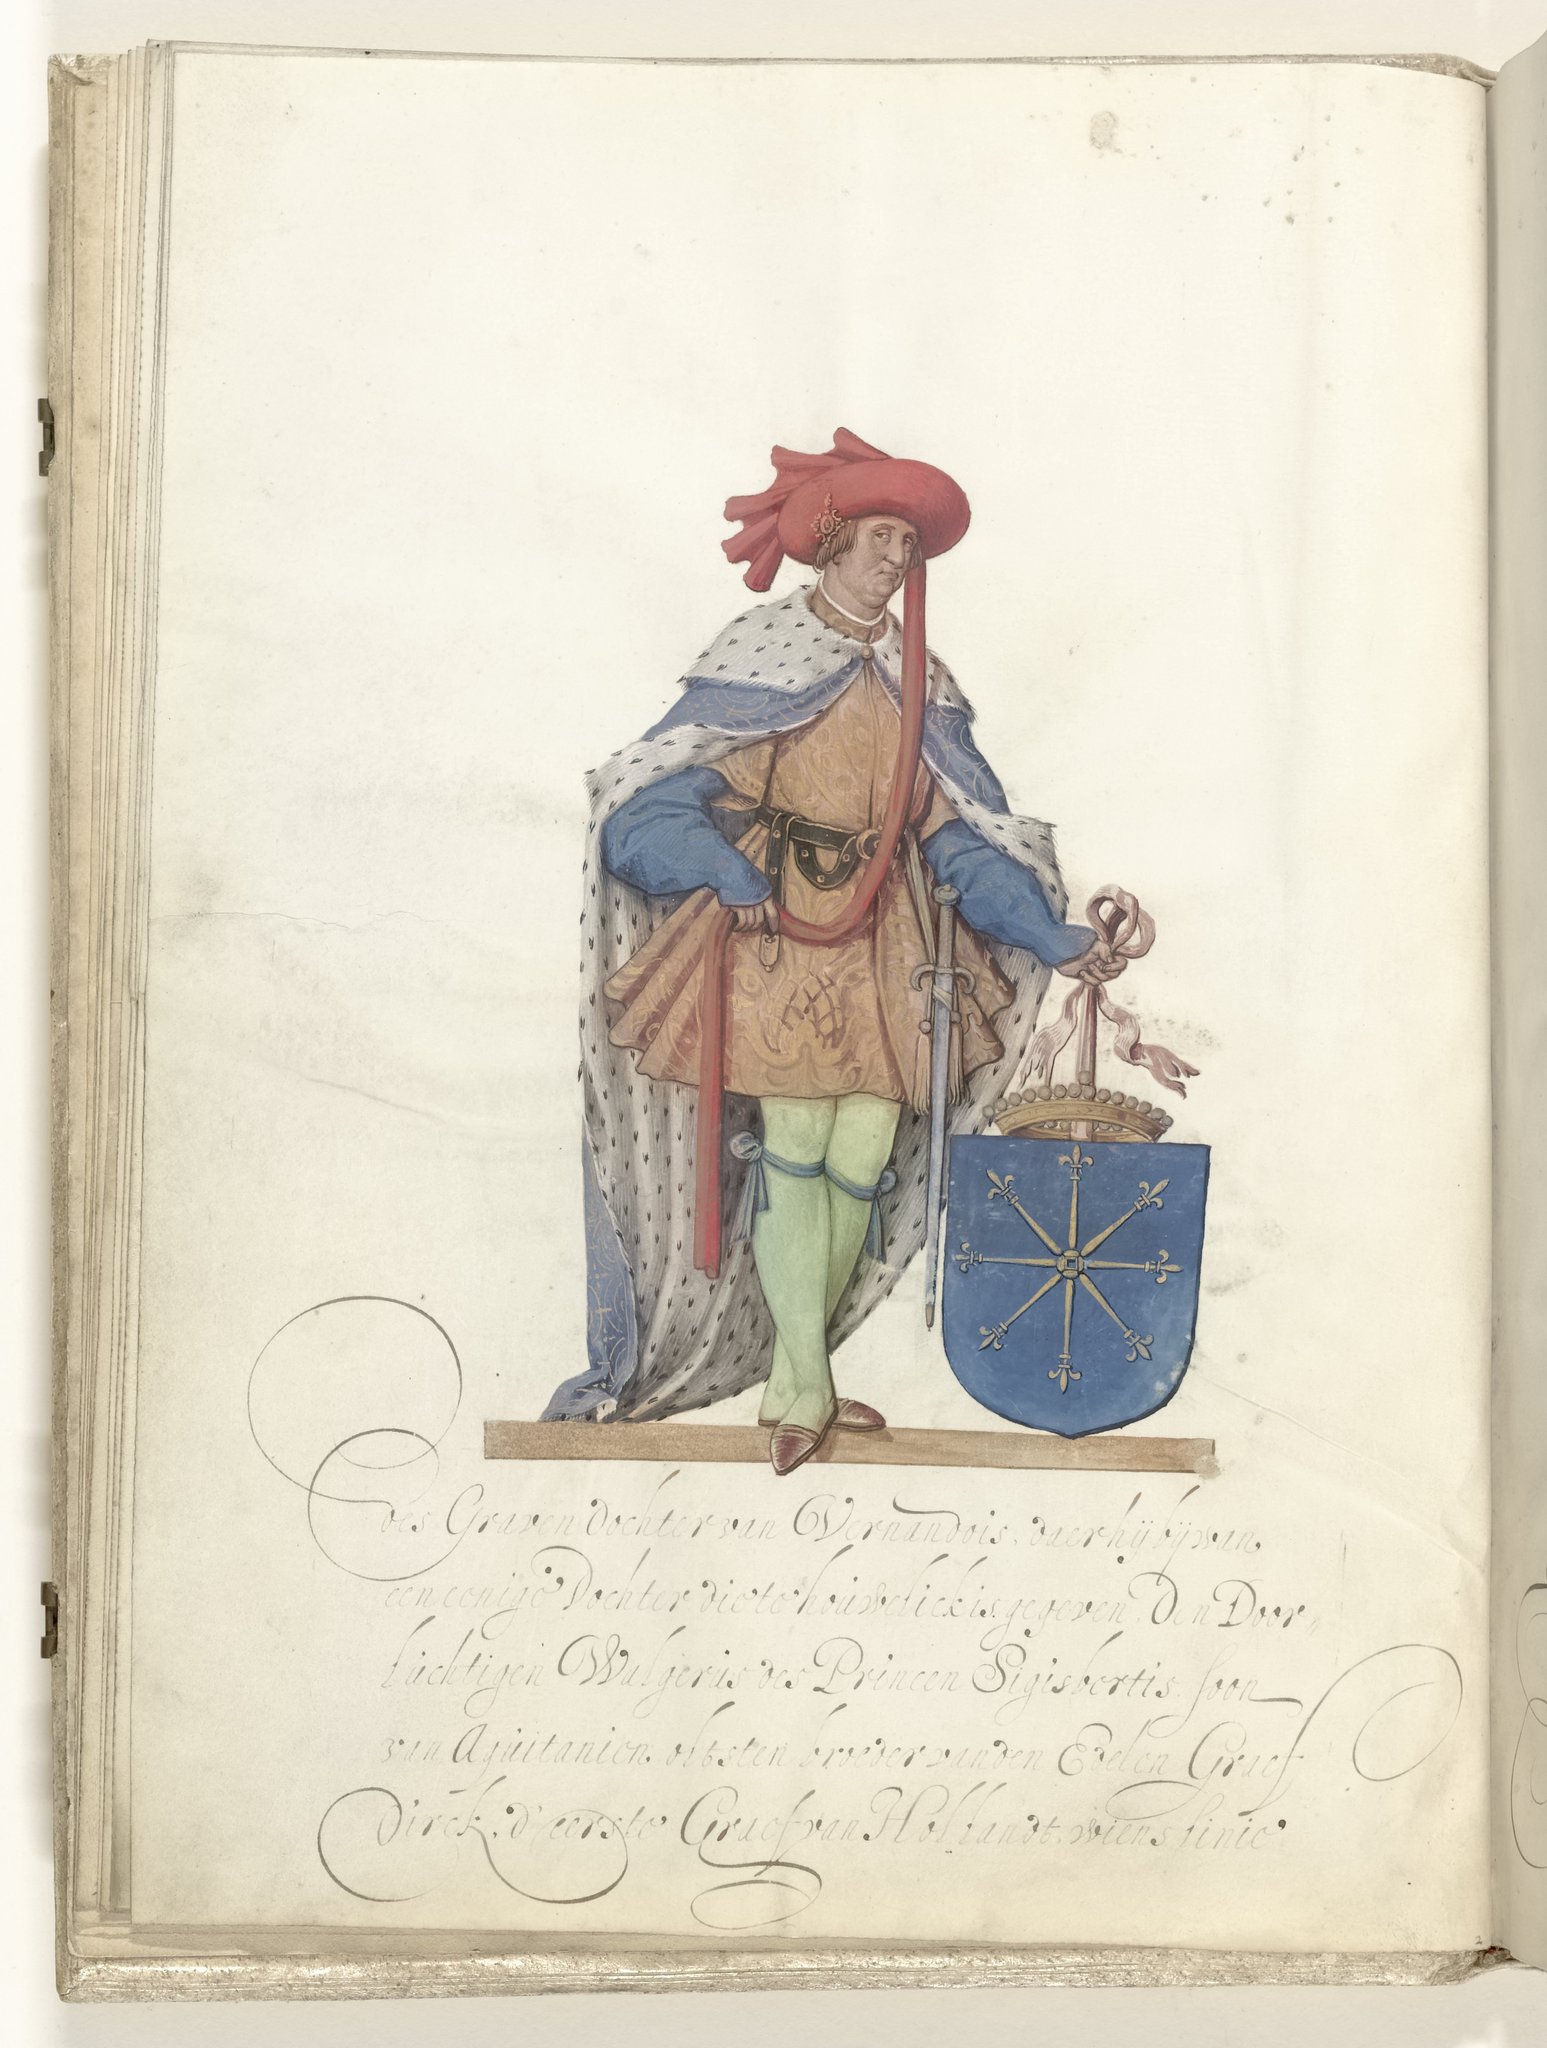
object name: drawing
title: Boudewijn van Teisterbant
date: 1590-1593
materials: paint, gouache, ink, parchment, watercolor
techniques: writing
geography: northern netherlands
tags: culemborg, heren en graven van, boudewijn graaf van teisterbant, graven van teisterbant, culemborg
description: De tekeningen worden op basis van archiefbronnen toegeschreven aan Nicolaes de Kemp (ca. 1550-1600) en worden gedateerd ca. 1590-1593. De teksten lijken gezien het handschrift begin 17de-eeuws.